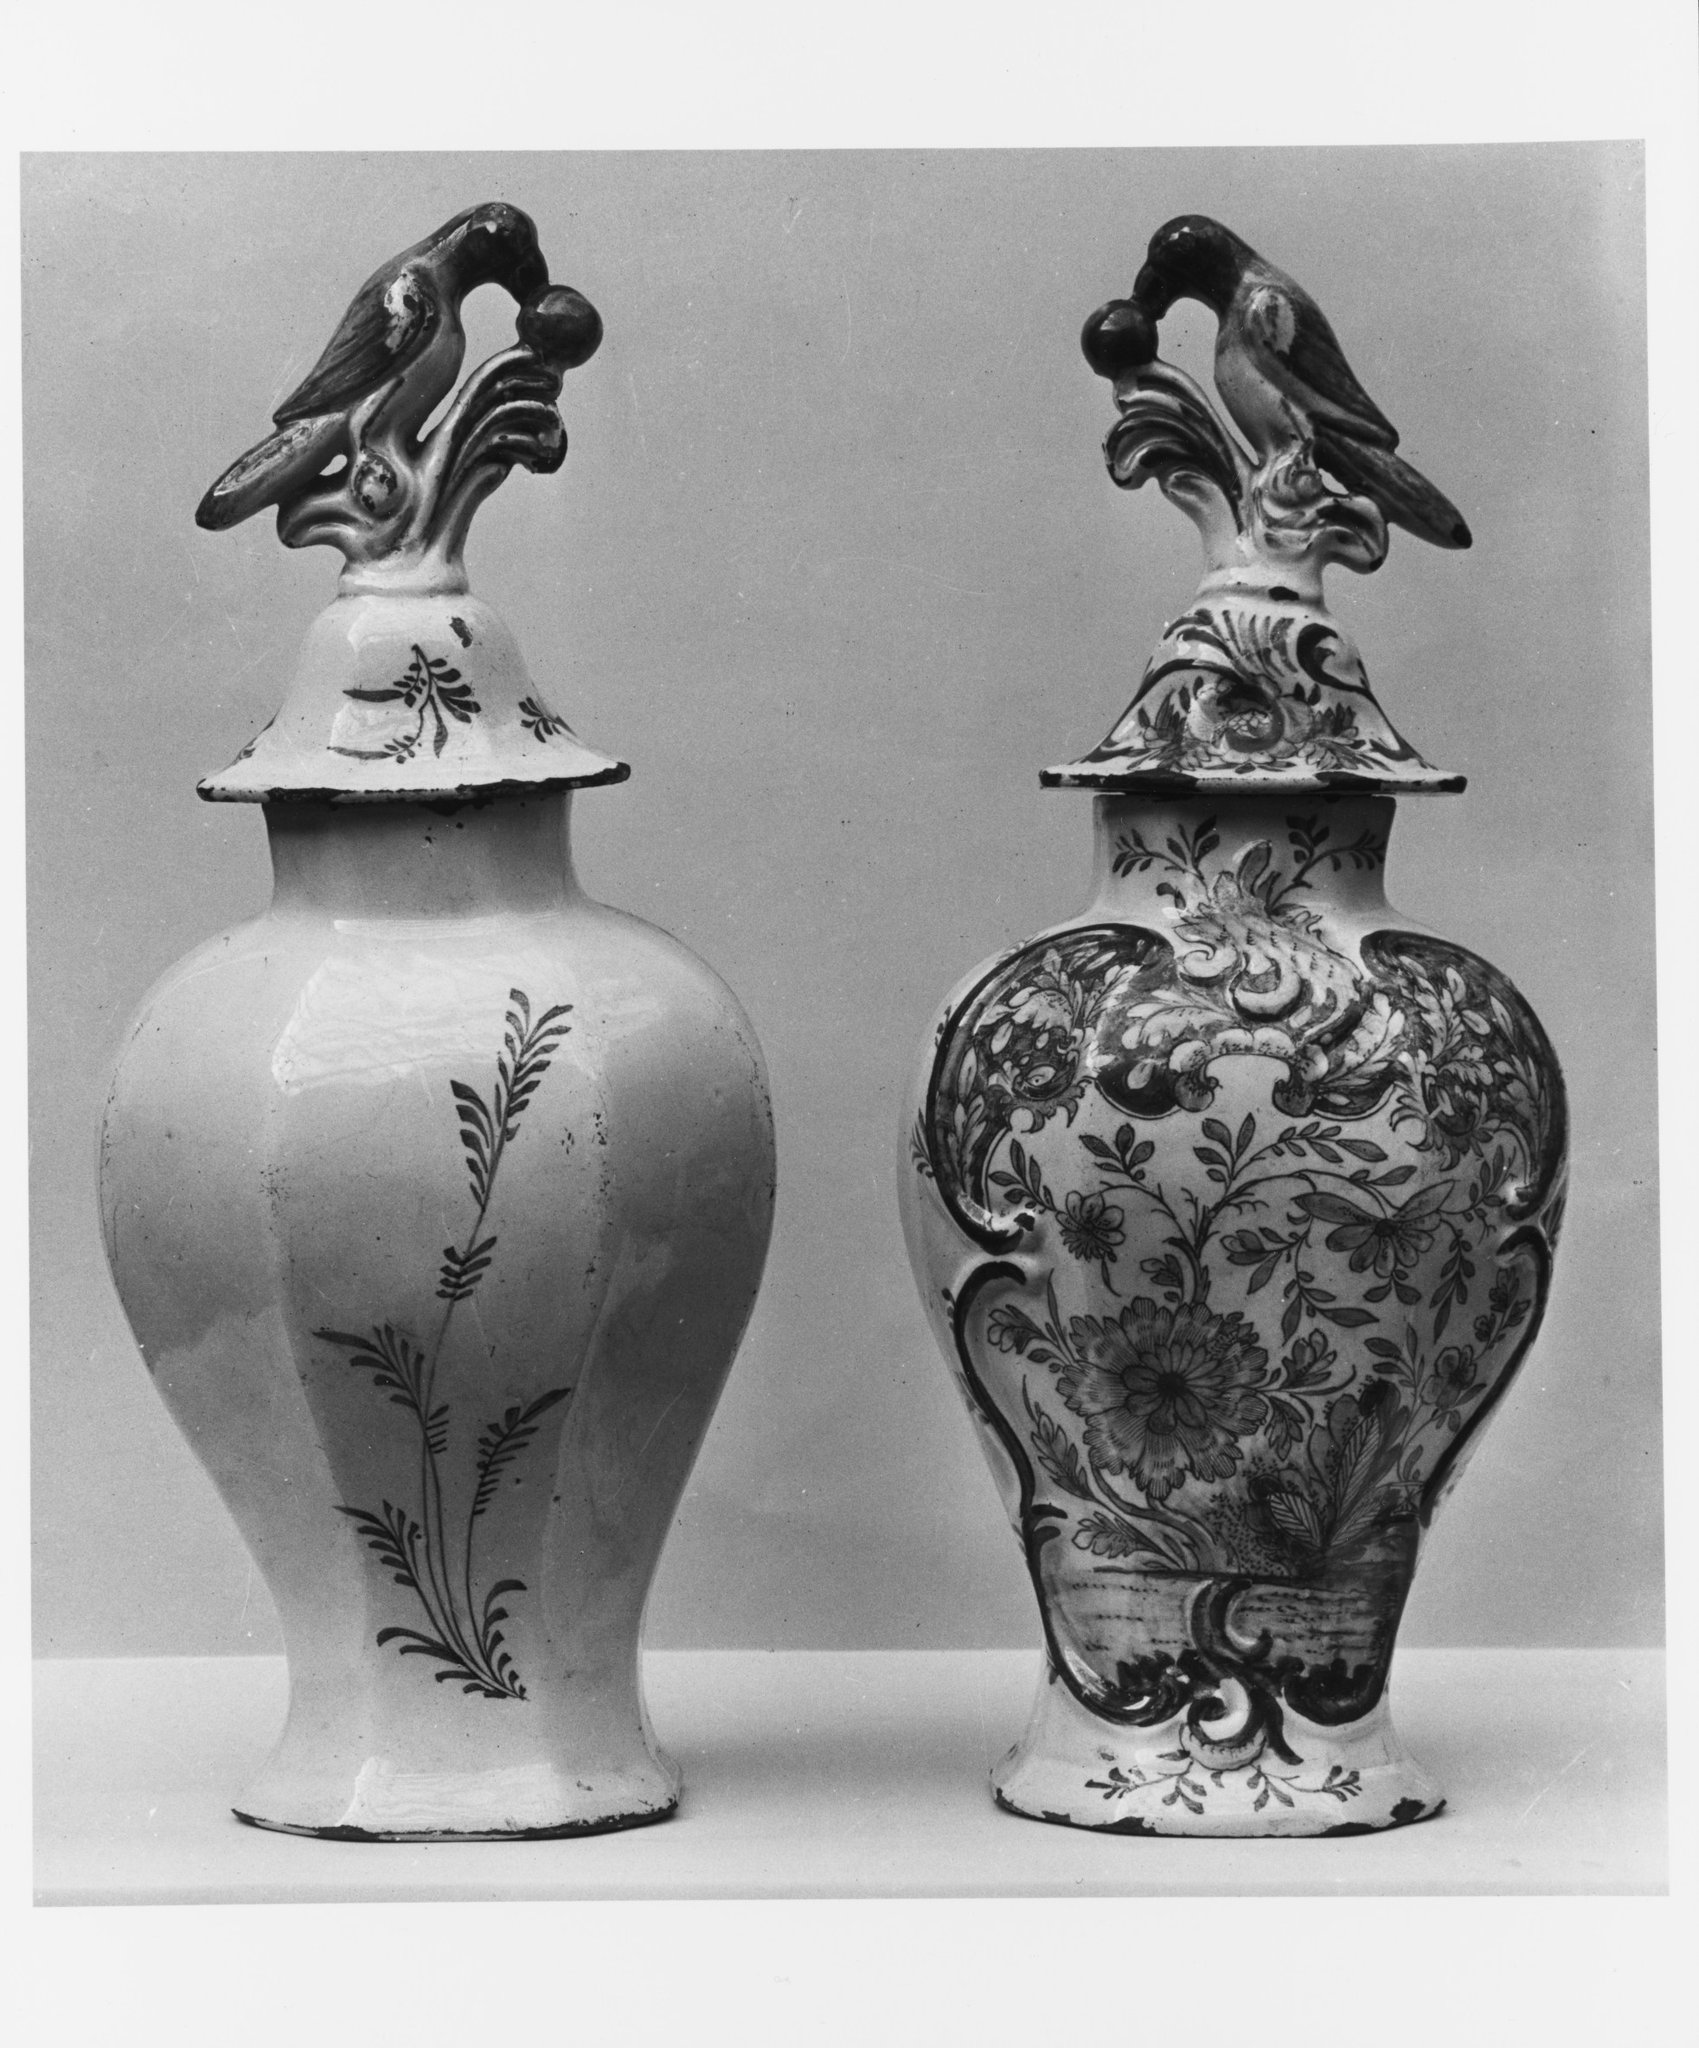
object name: jar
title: Covered Jar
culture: dutch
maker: justus brouwer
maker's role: designer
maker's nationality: dutch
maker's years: 1739-1775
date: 1739-1775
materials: earthenware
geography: netherlands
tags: birds,flowers